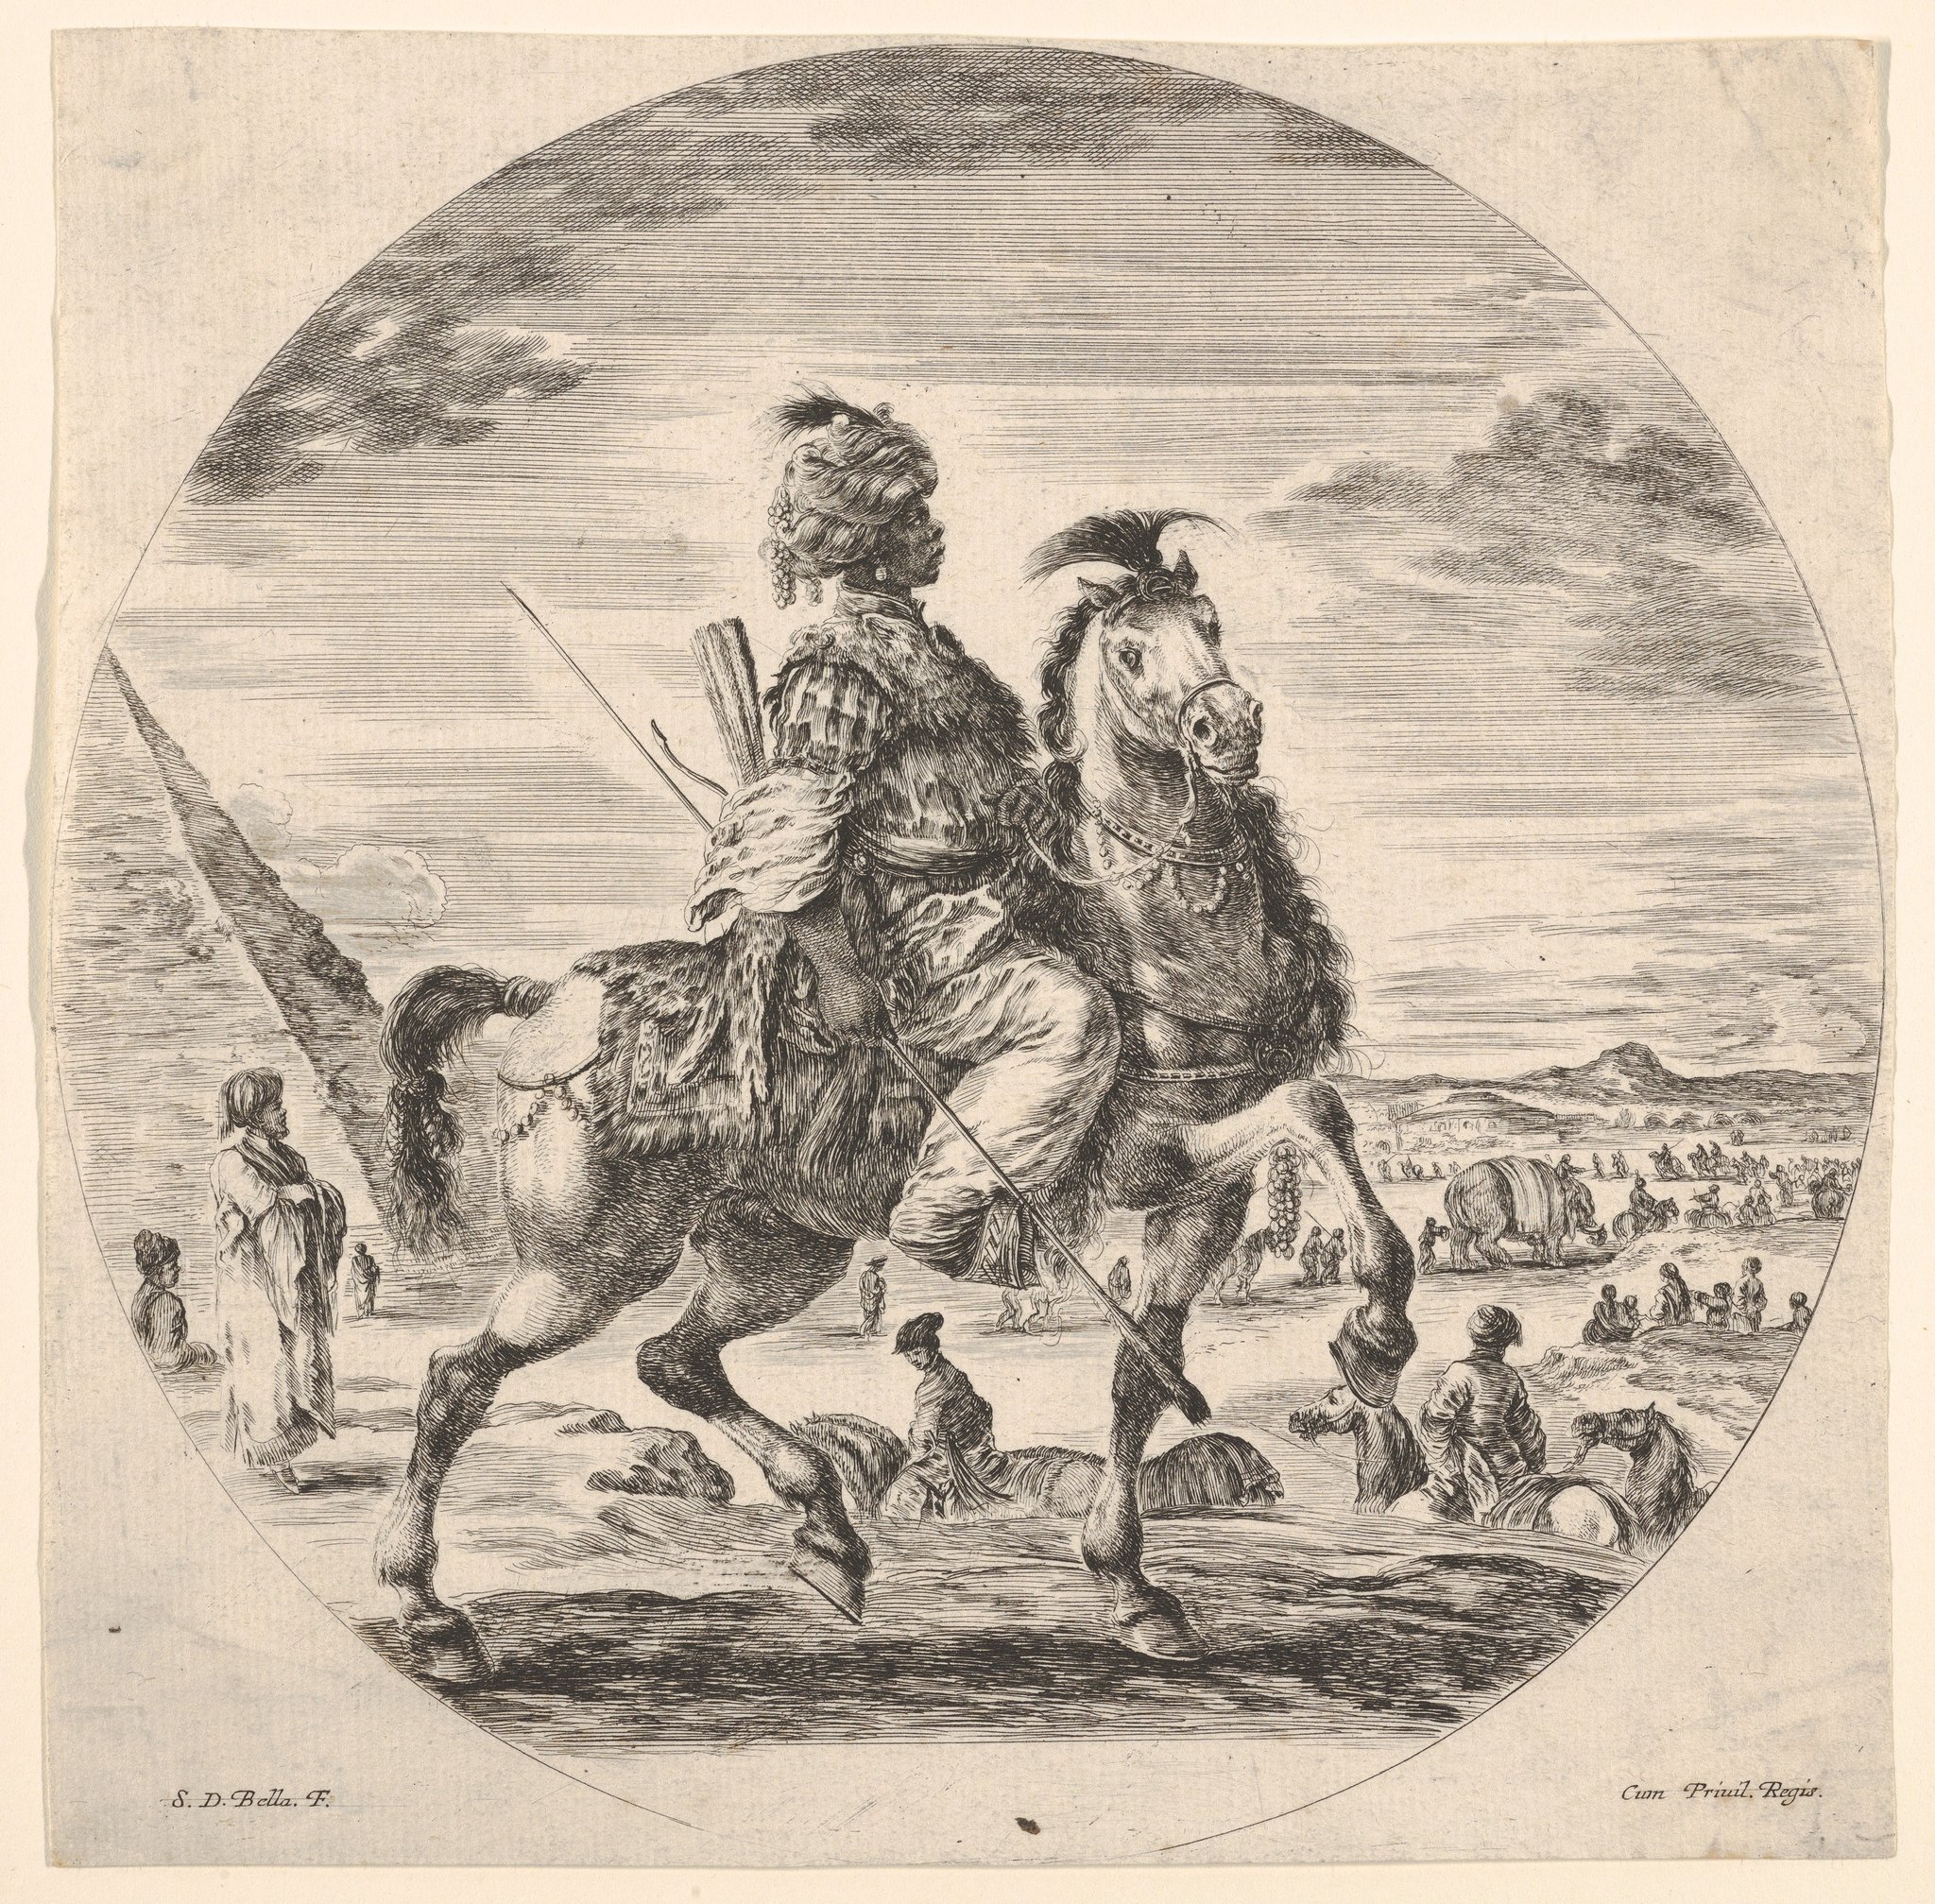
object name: print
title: Moorish horseman in profile facing right, in the background a pyramid at left, many figures and an elephant, from "Figures on Horseback" (Cavaliers nègres, polonais et hongrois)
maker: stefano della bella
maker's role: artist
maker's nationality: italian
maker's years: 1610-1664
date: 1648-1653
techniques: etching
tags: men,horses